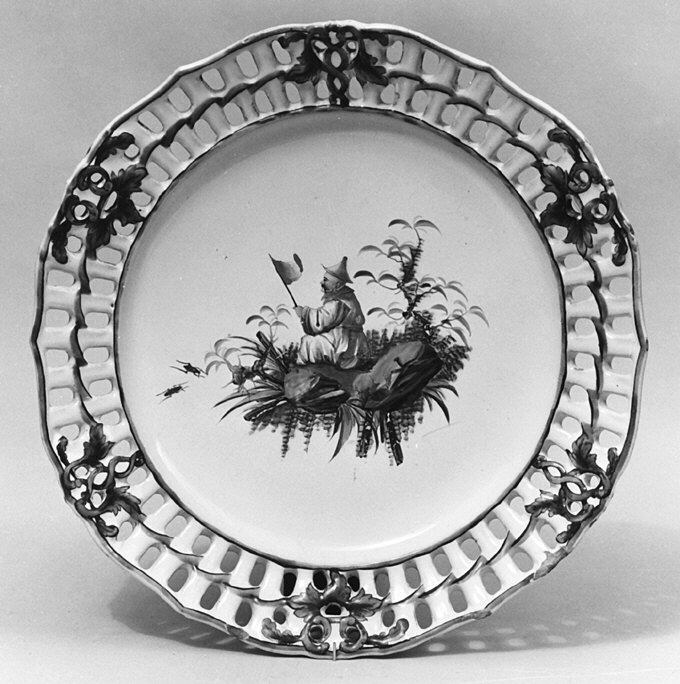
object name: plate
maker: joseph hannong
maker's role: maker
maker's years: 1755-1780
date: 1760-1780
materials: faience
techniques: glazing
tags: chinoiserie,men,insects